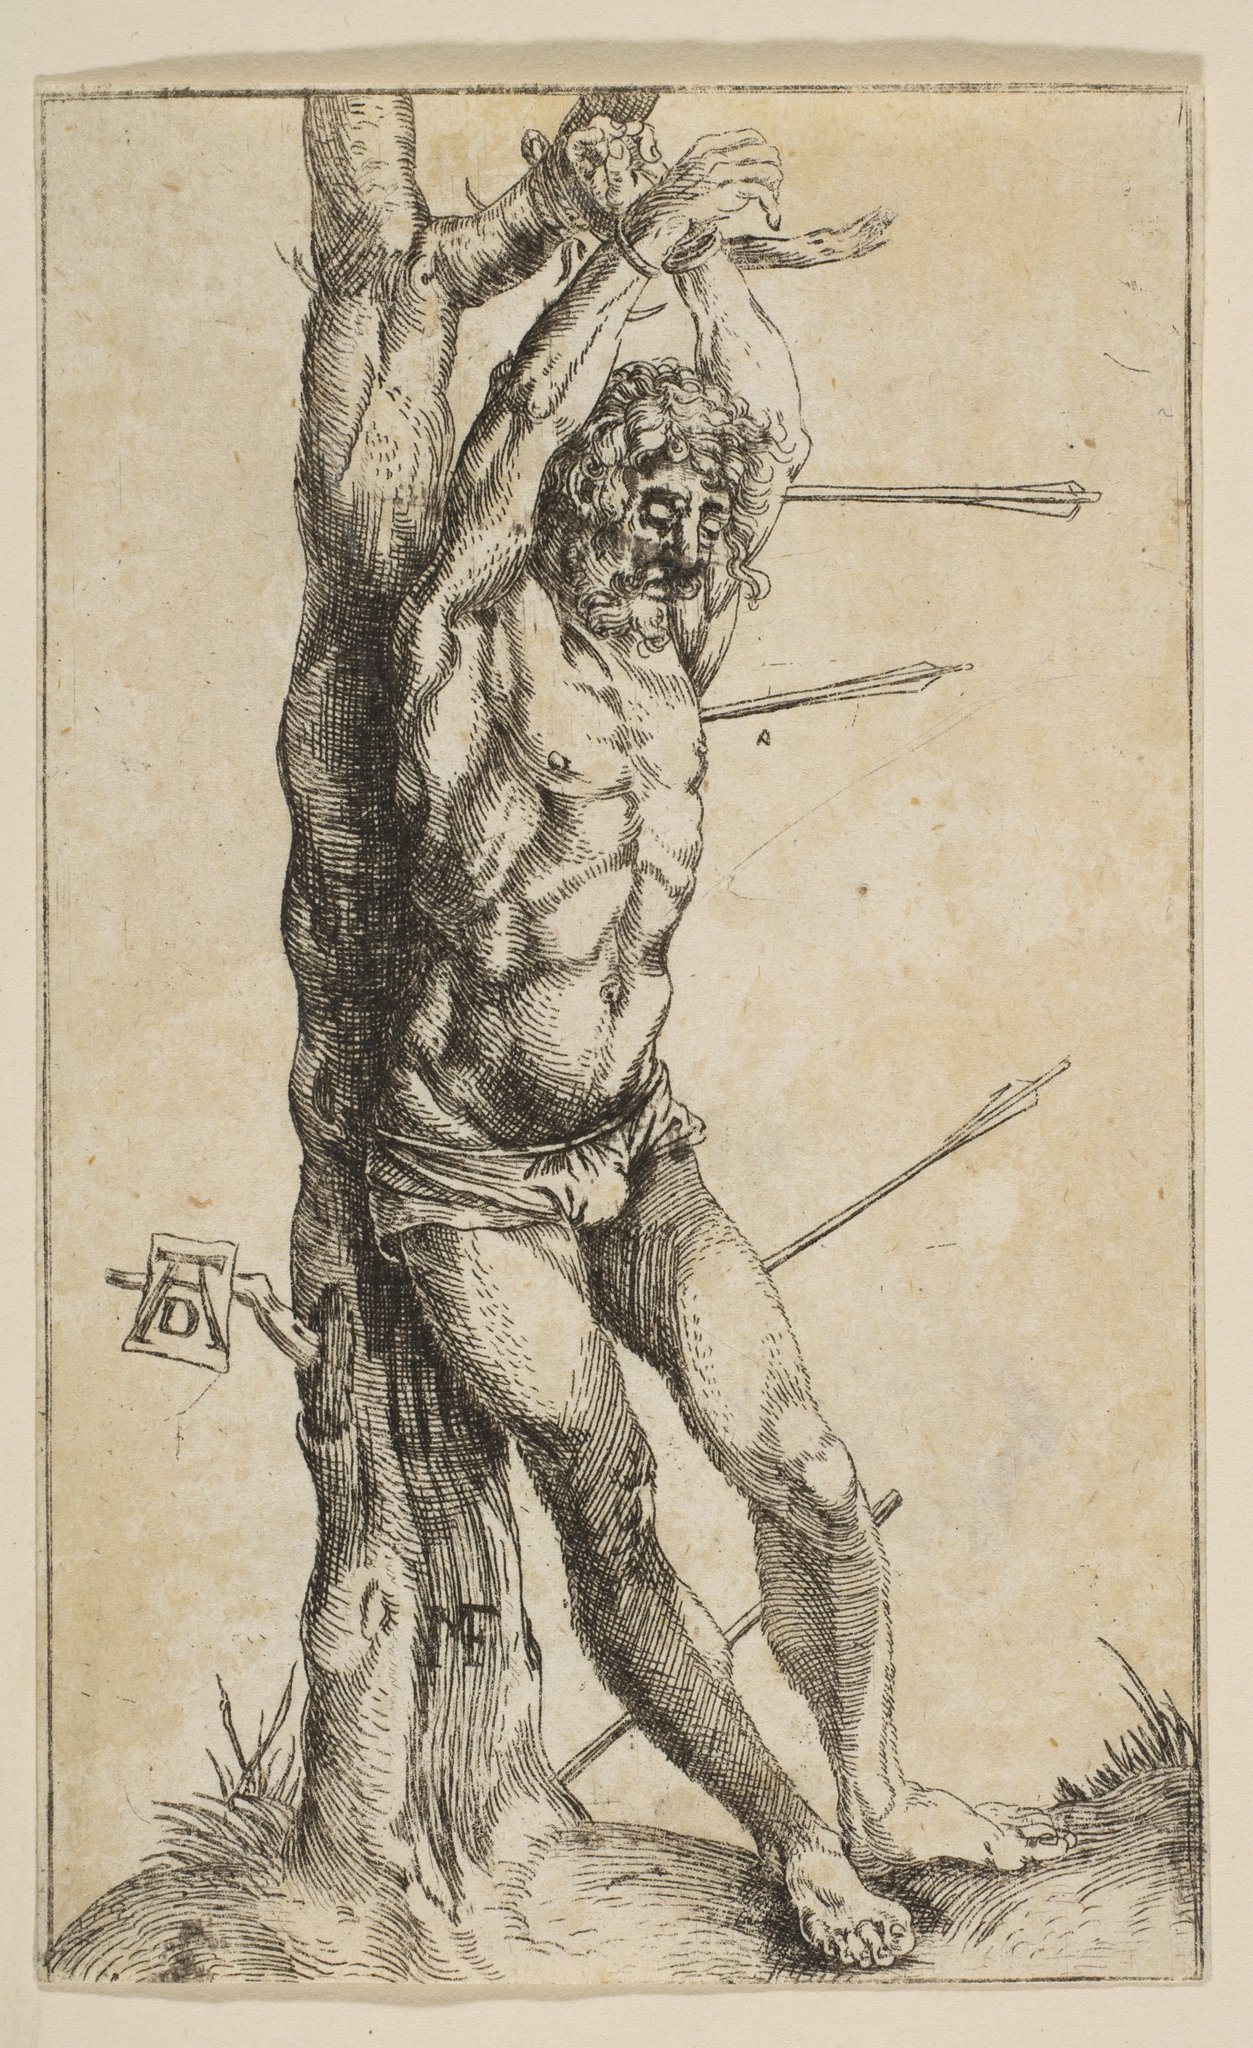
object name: print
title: Saint Sebastian Tied to a Tree (reverse copy)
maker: albrecht dürer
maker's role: artist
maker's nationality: german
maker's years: 1471-1528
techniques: engraving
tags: arrows,suffering,trees,saints